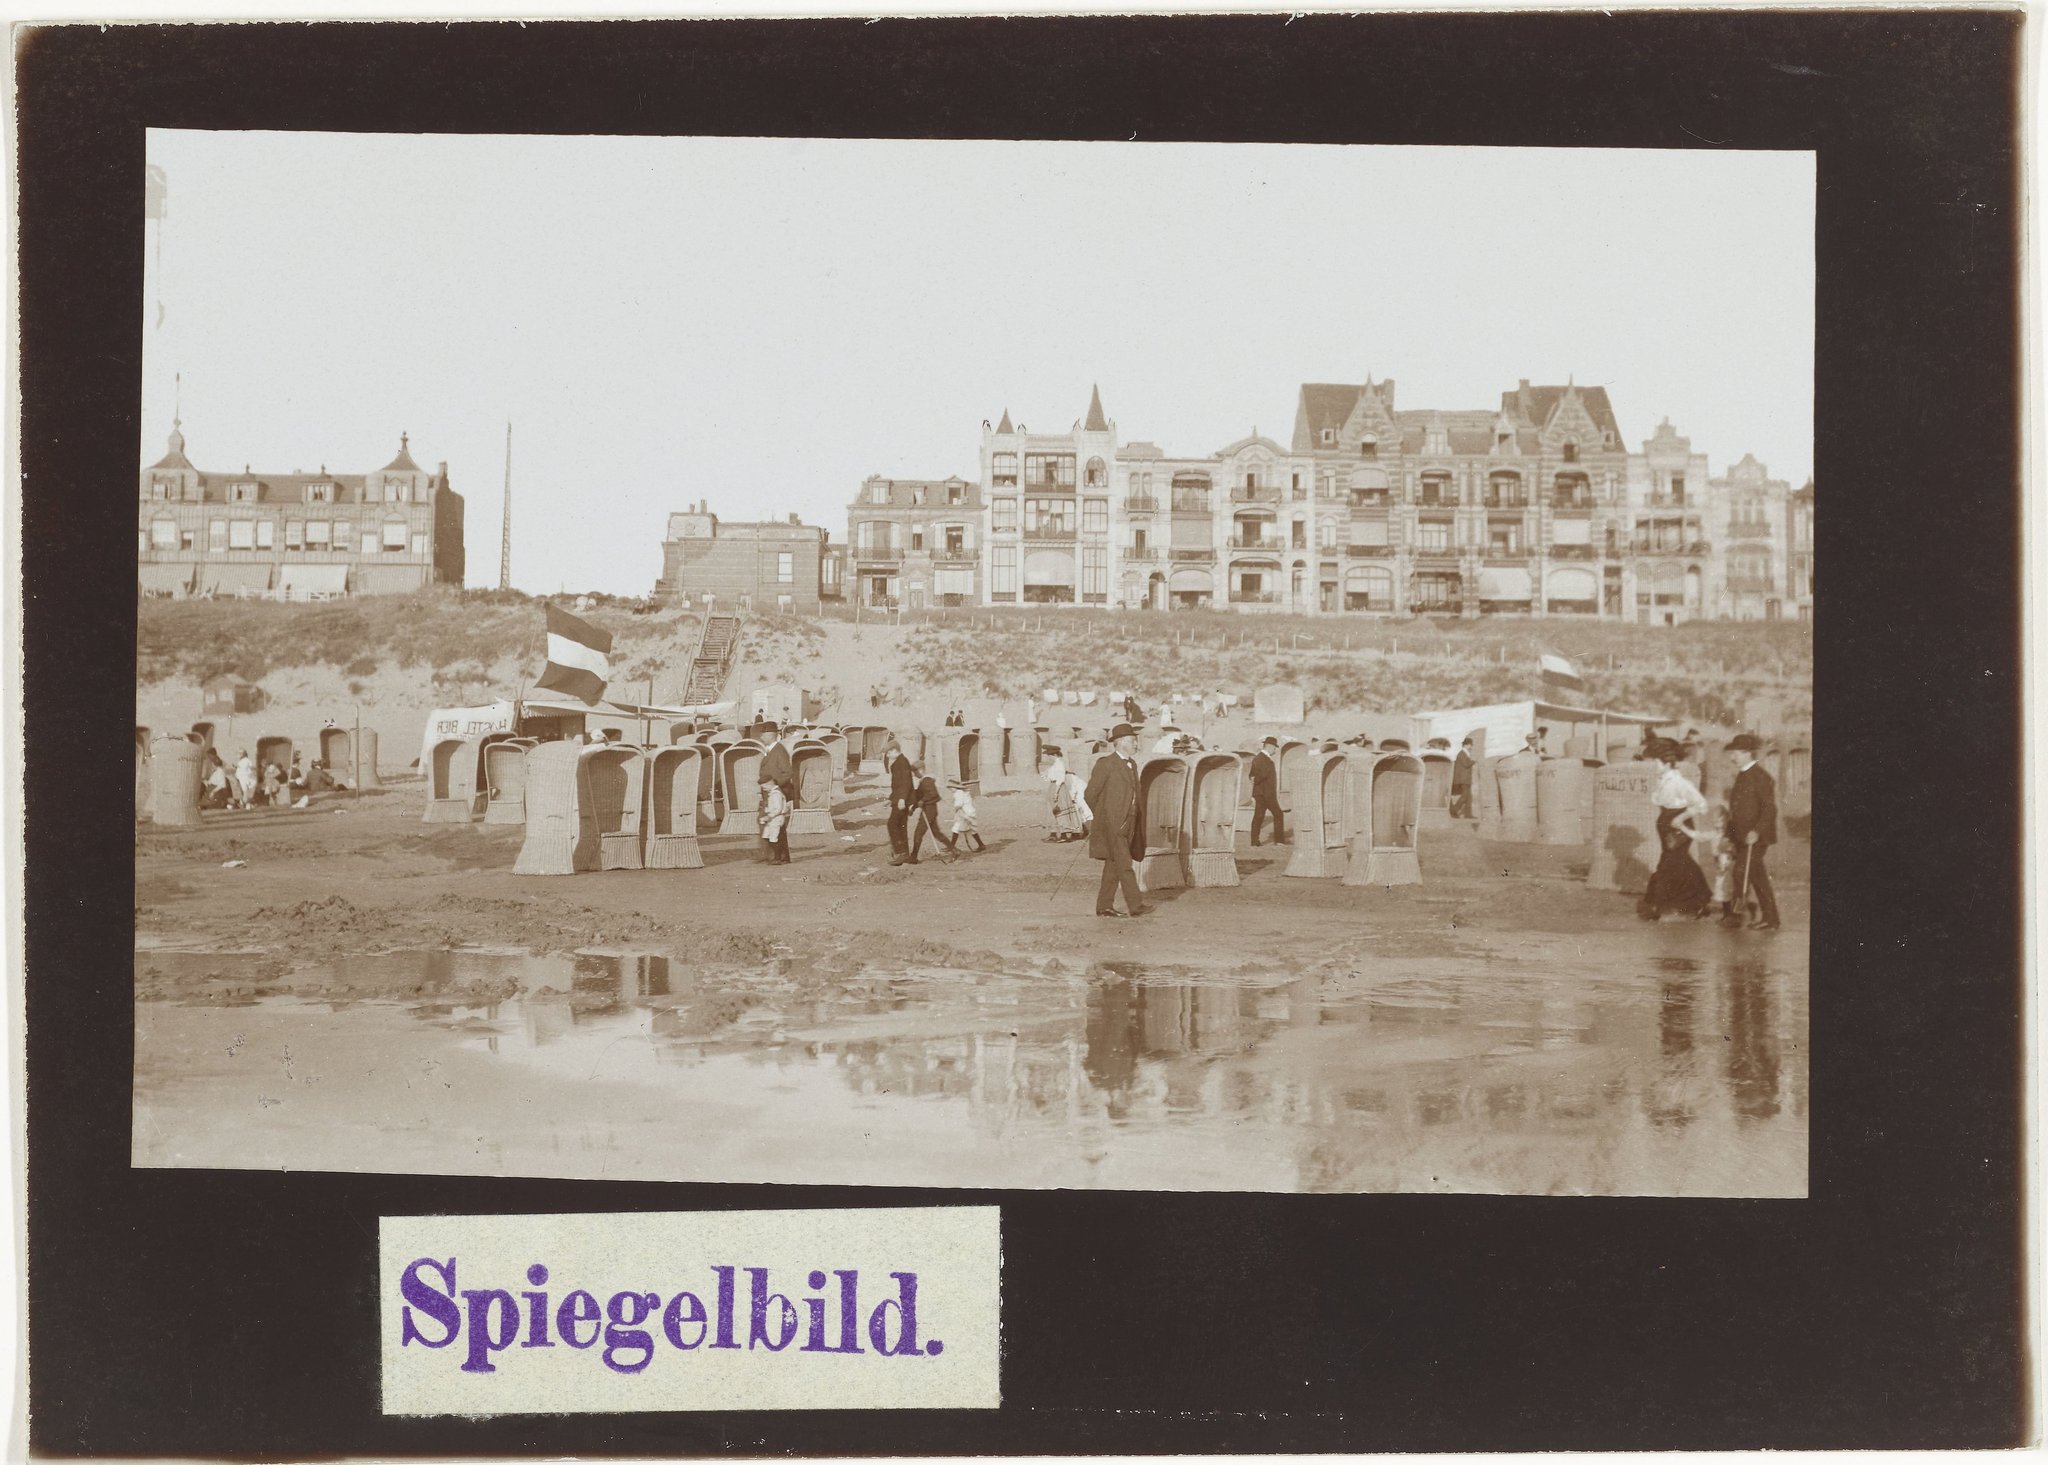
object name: photograph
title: Strandstoelen op het strand in Zandvoort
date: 1900-1905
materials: photographic support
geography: zandvoort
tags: beach (as place of recreation)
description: Lege strandstoelen op het strand en hotels langs de boulevard. Weinig mensen. Links een grote Nederlandse vlag. M.o. opschrift 'Spiegelbild'.